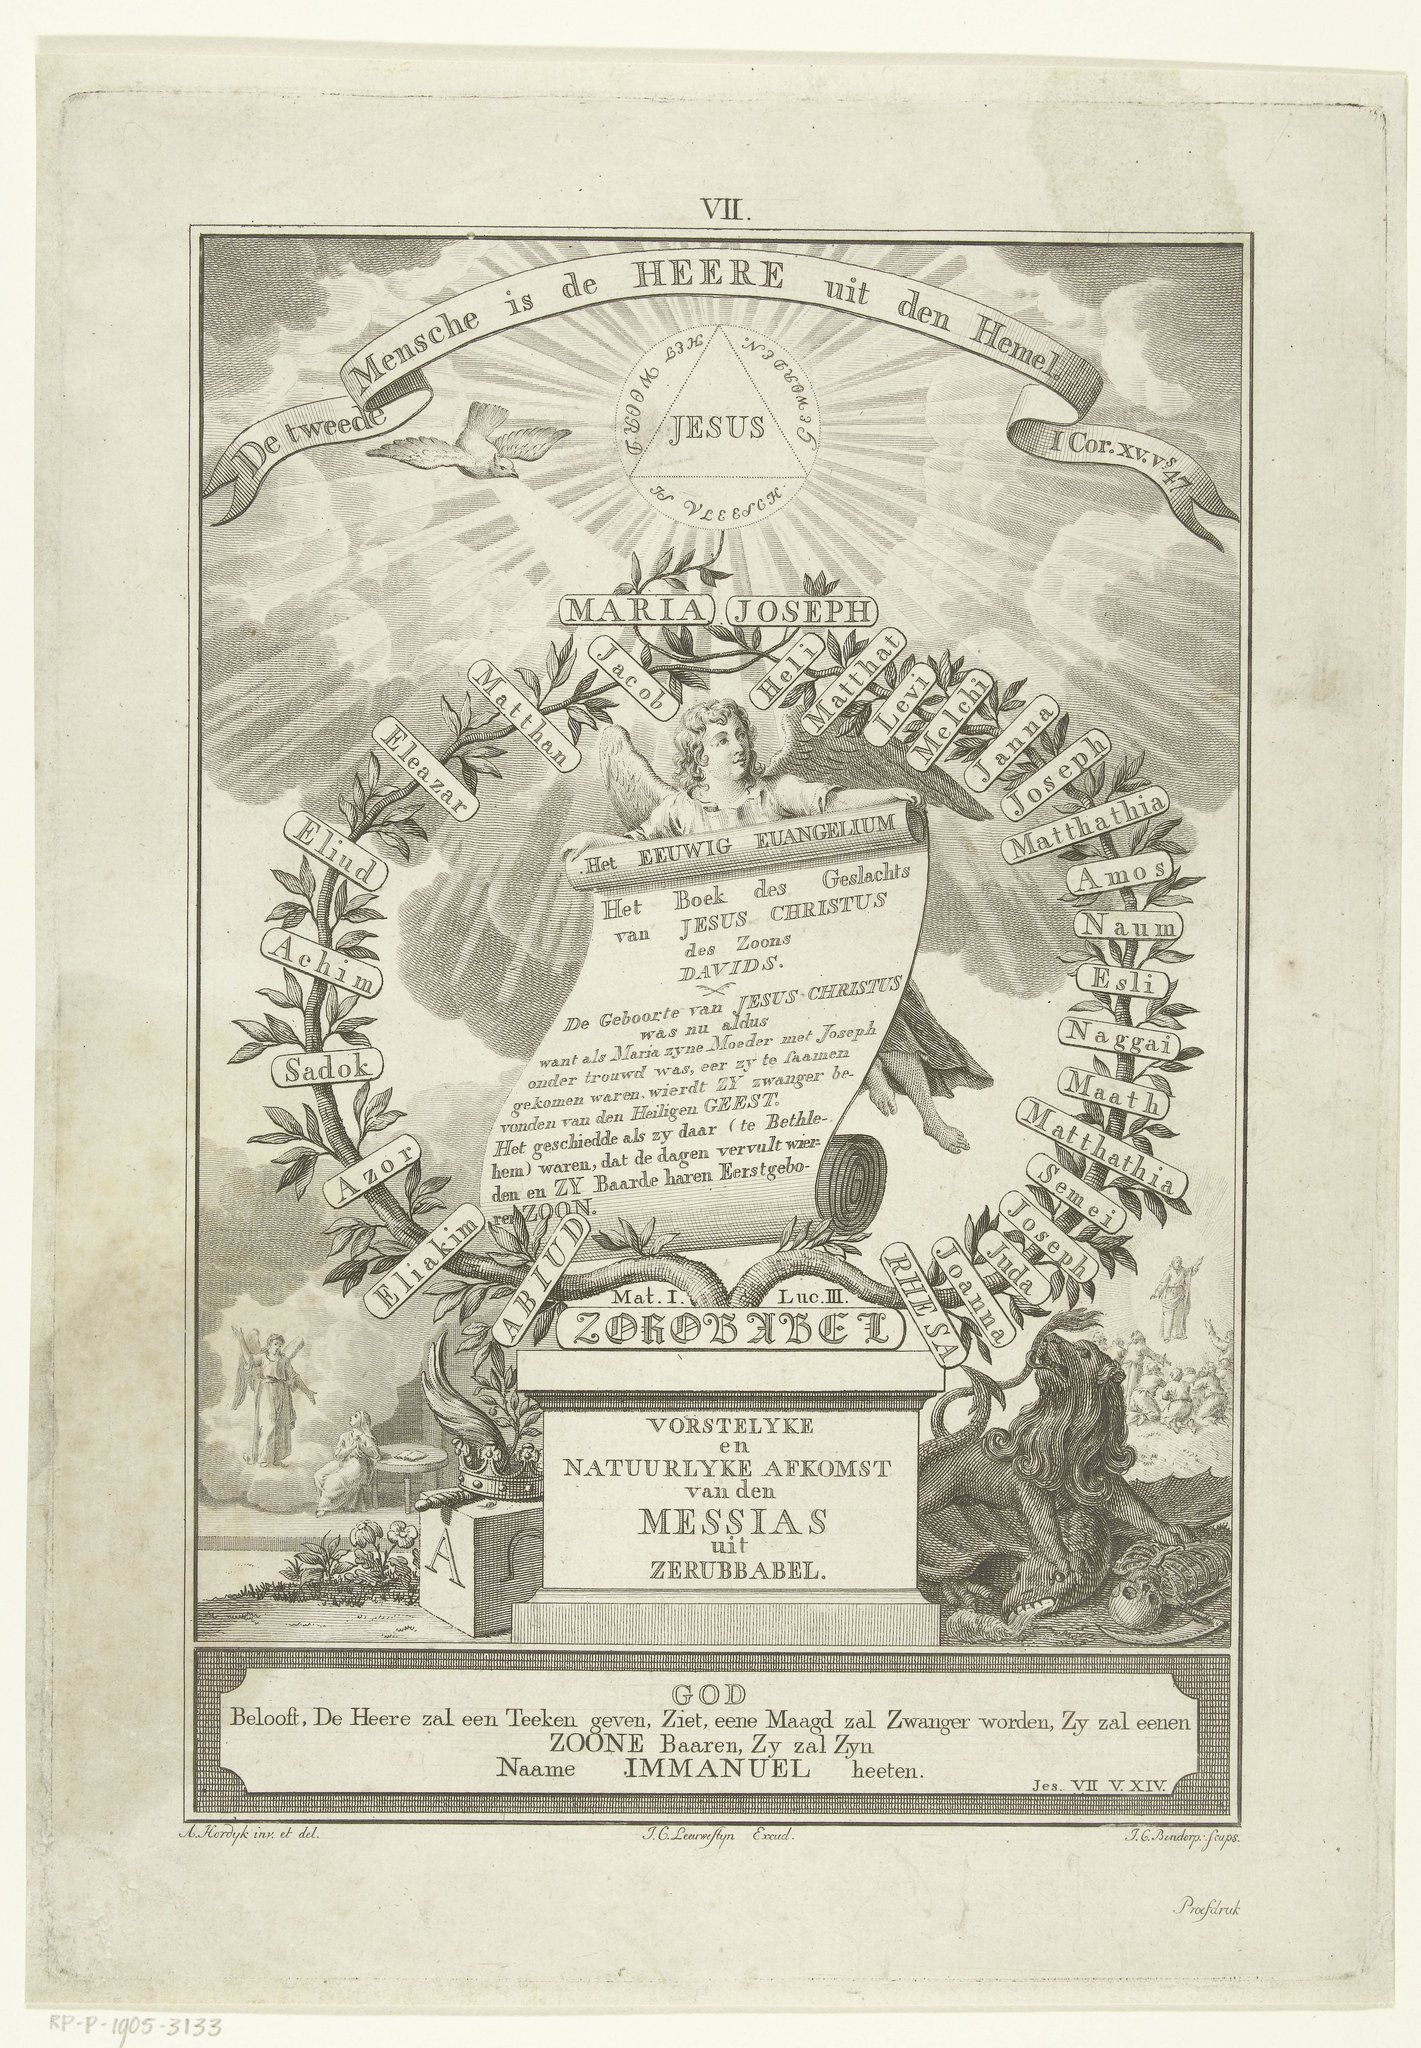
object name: print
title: Stamboom met afkomst Christus van Zerubbabel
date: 1776-1849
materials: paper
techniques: etching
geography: netherlands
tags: ancestors and parents of christ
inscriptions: collector's mark: Lugt 2228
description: Stamboom met namen van de geslachten waaruit Maria en Jozef afkomstig zijn, illustreert de afkomst van Christus van Zerubbabel zoals beschreven bij Matteüs I en Lukas 3. De stamboom staat op een voetstuk dat geflankeerd wordt door symbolen van de Nederlandse staat. Twee kleine scènes links en rechts: de boodschap van de engel Gabriël aan Maria en Christus verschijnt voor zijn discipelen. Een engel houdt een rol papier vast met daarop de tekst Eeuwig Evangelium en verklaring over de geboorte van Christus.